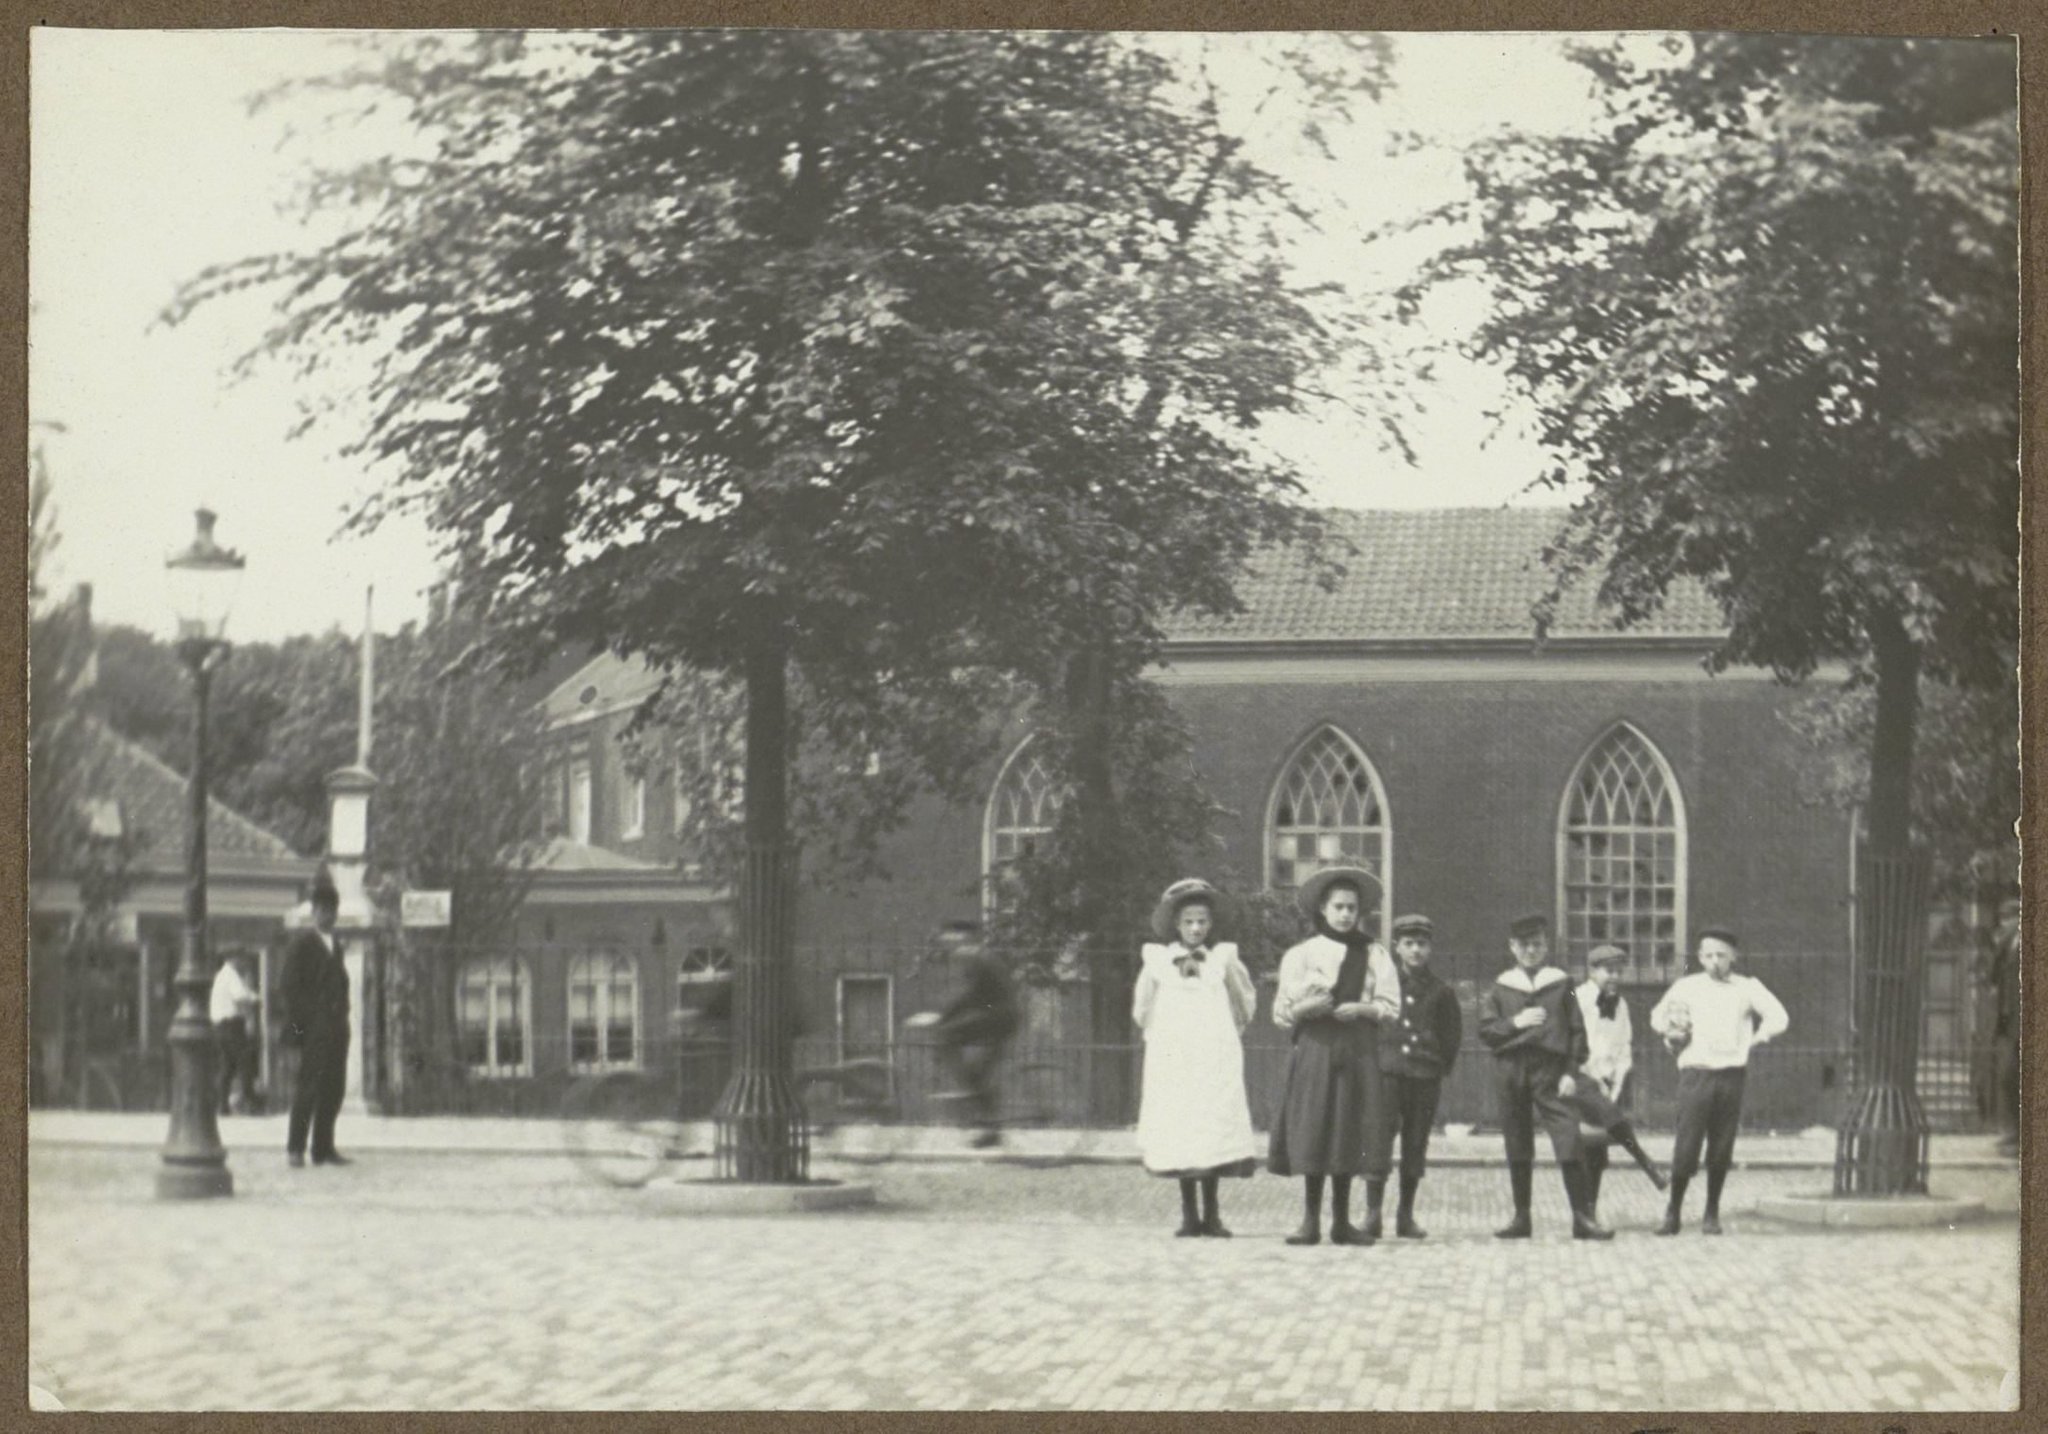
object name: photograph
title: Kinderen voor Kapel de Liefde in de Bilderdijkstraat te Amsterdam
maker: Anonymous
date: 1910-1930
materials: paper, photographic support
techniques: gelatin silver print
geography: amsterdam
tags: church (exterior) - qq - small church, chapel, amsterdam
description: Onderdeel van Album met foto's van Amsterdam en omgeving.